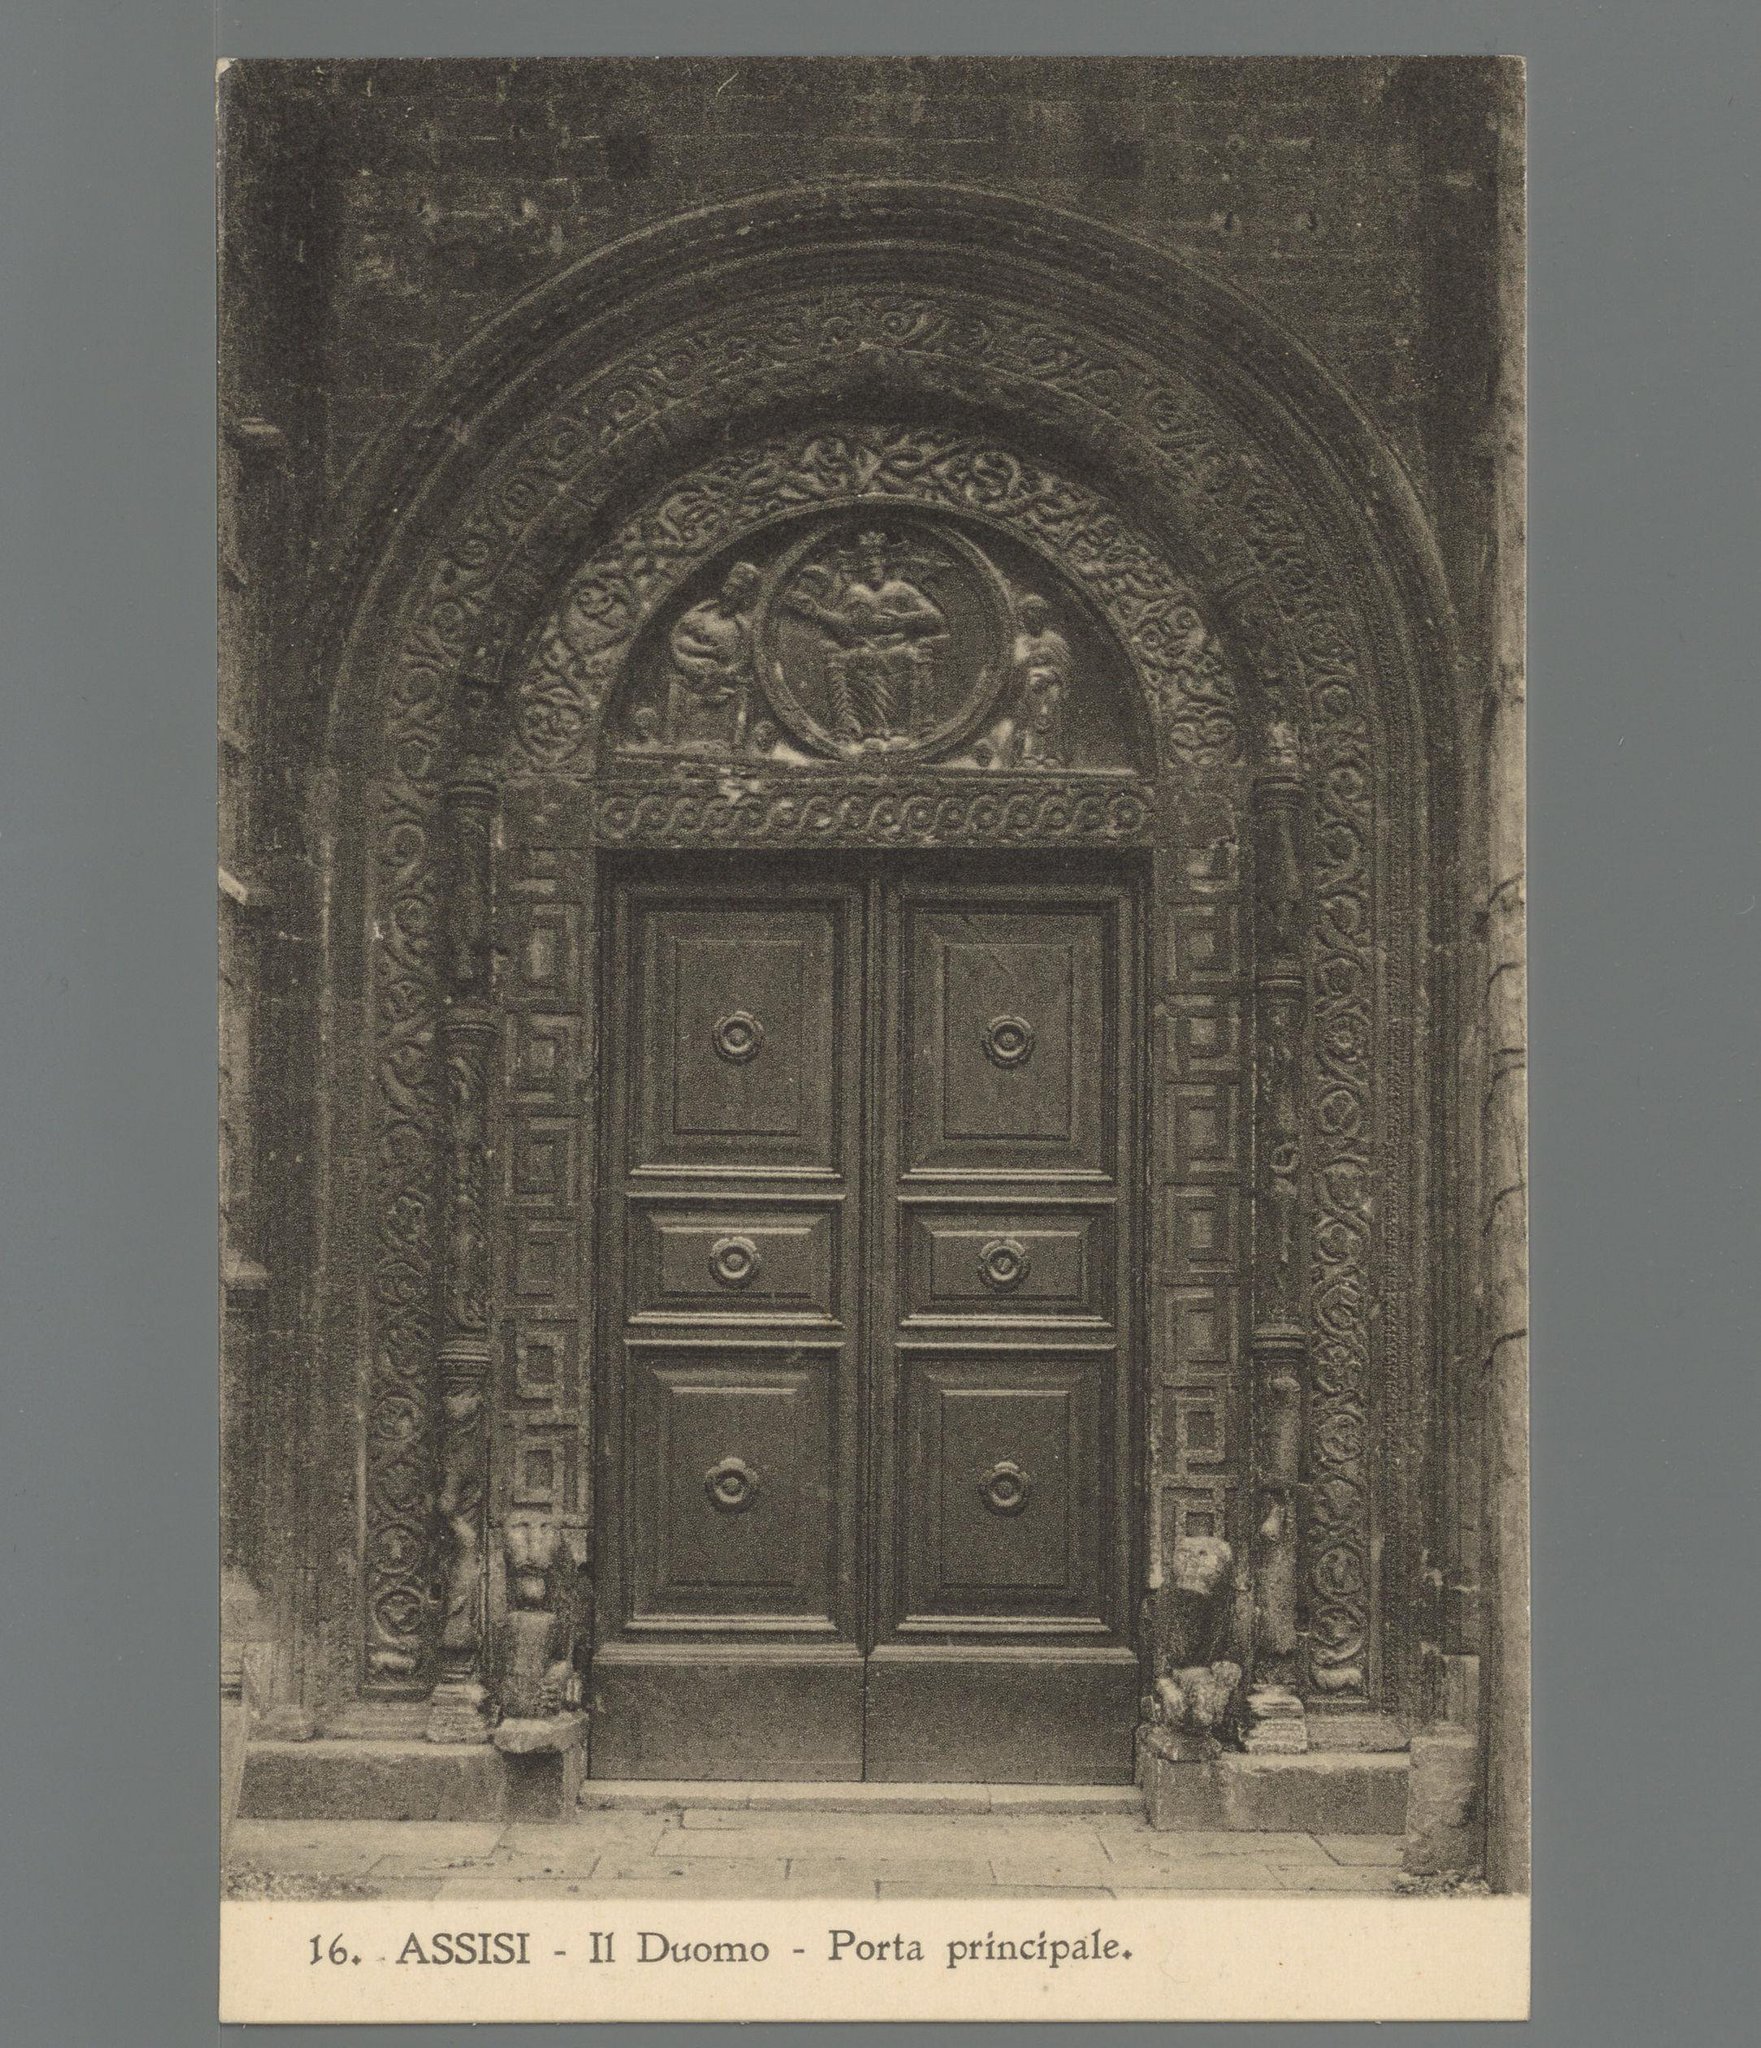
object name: ansichtkaart, prentbriefkaart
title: Assisi. Il Duomo. Porta principale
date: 1906-1930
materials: cardboard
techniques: photograph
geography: assisi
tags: parts of church exterior and annexes: portal